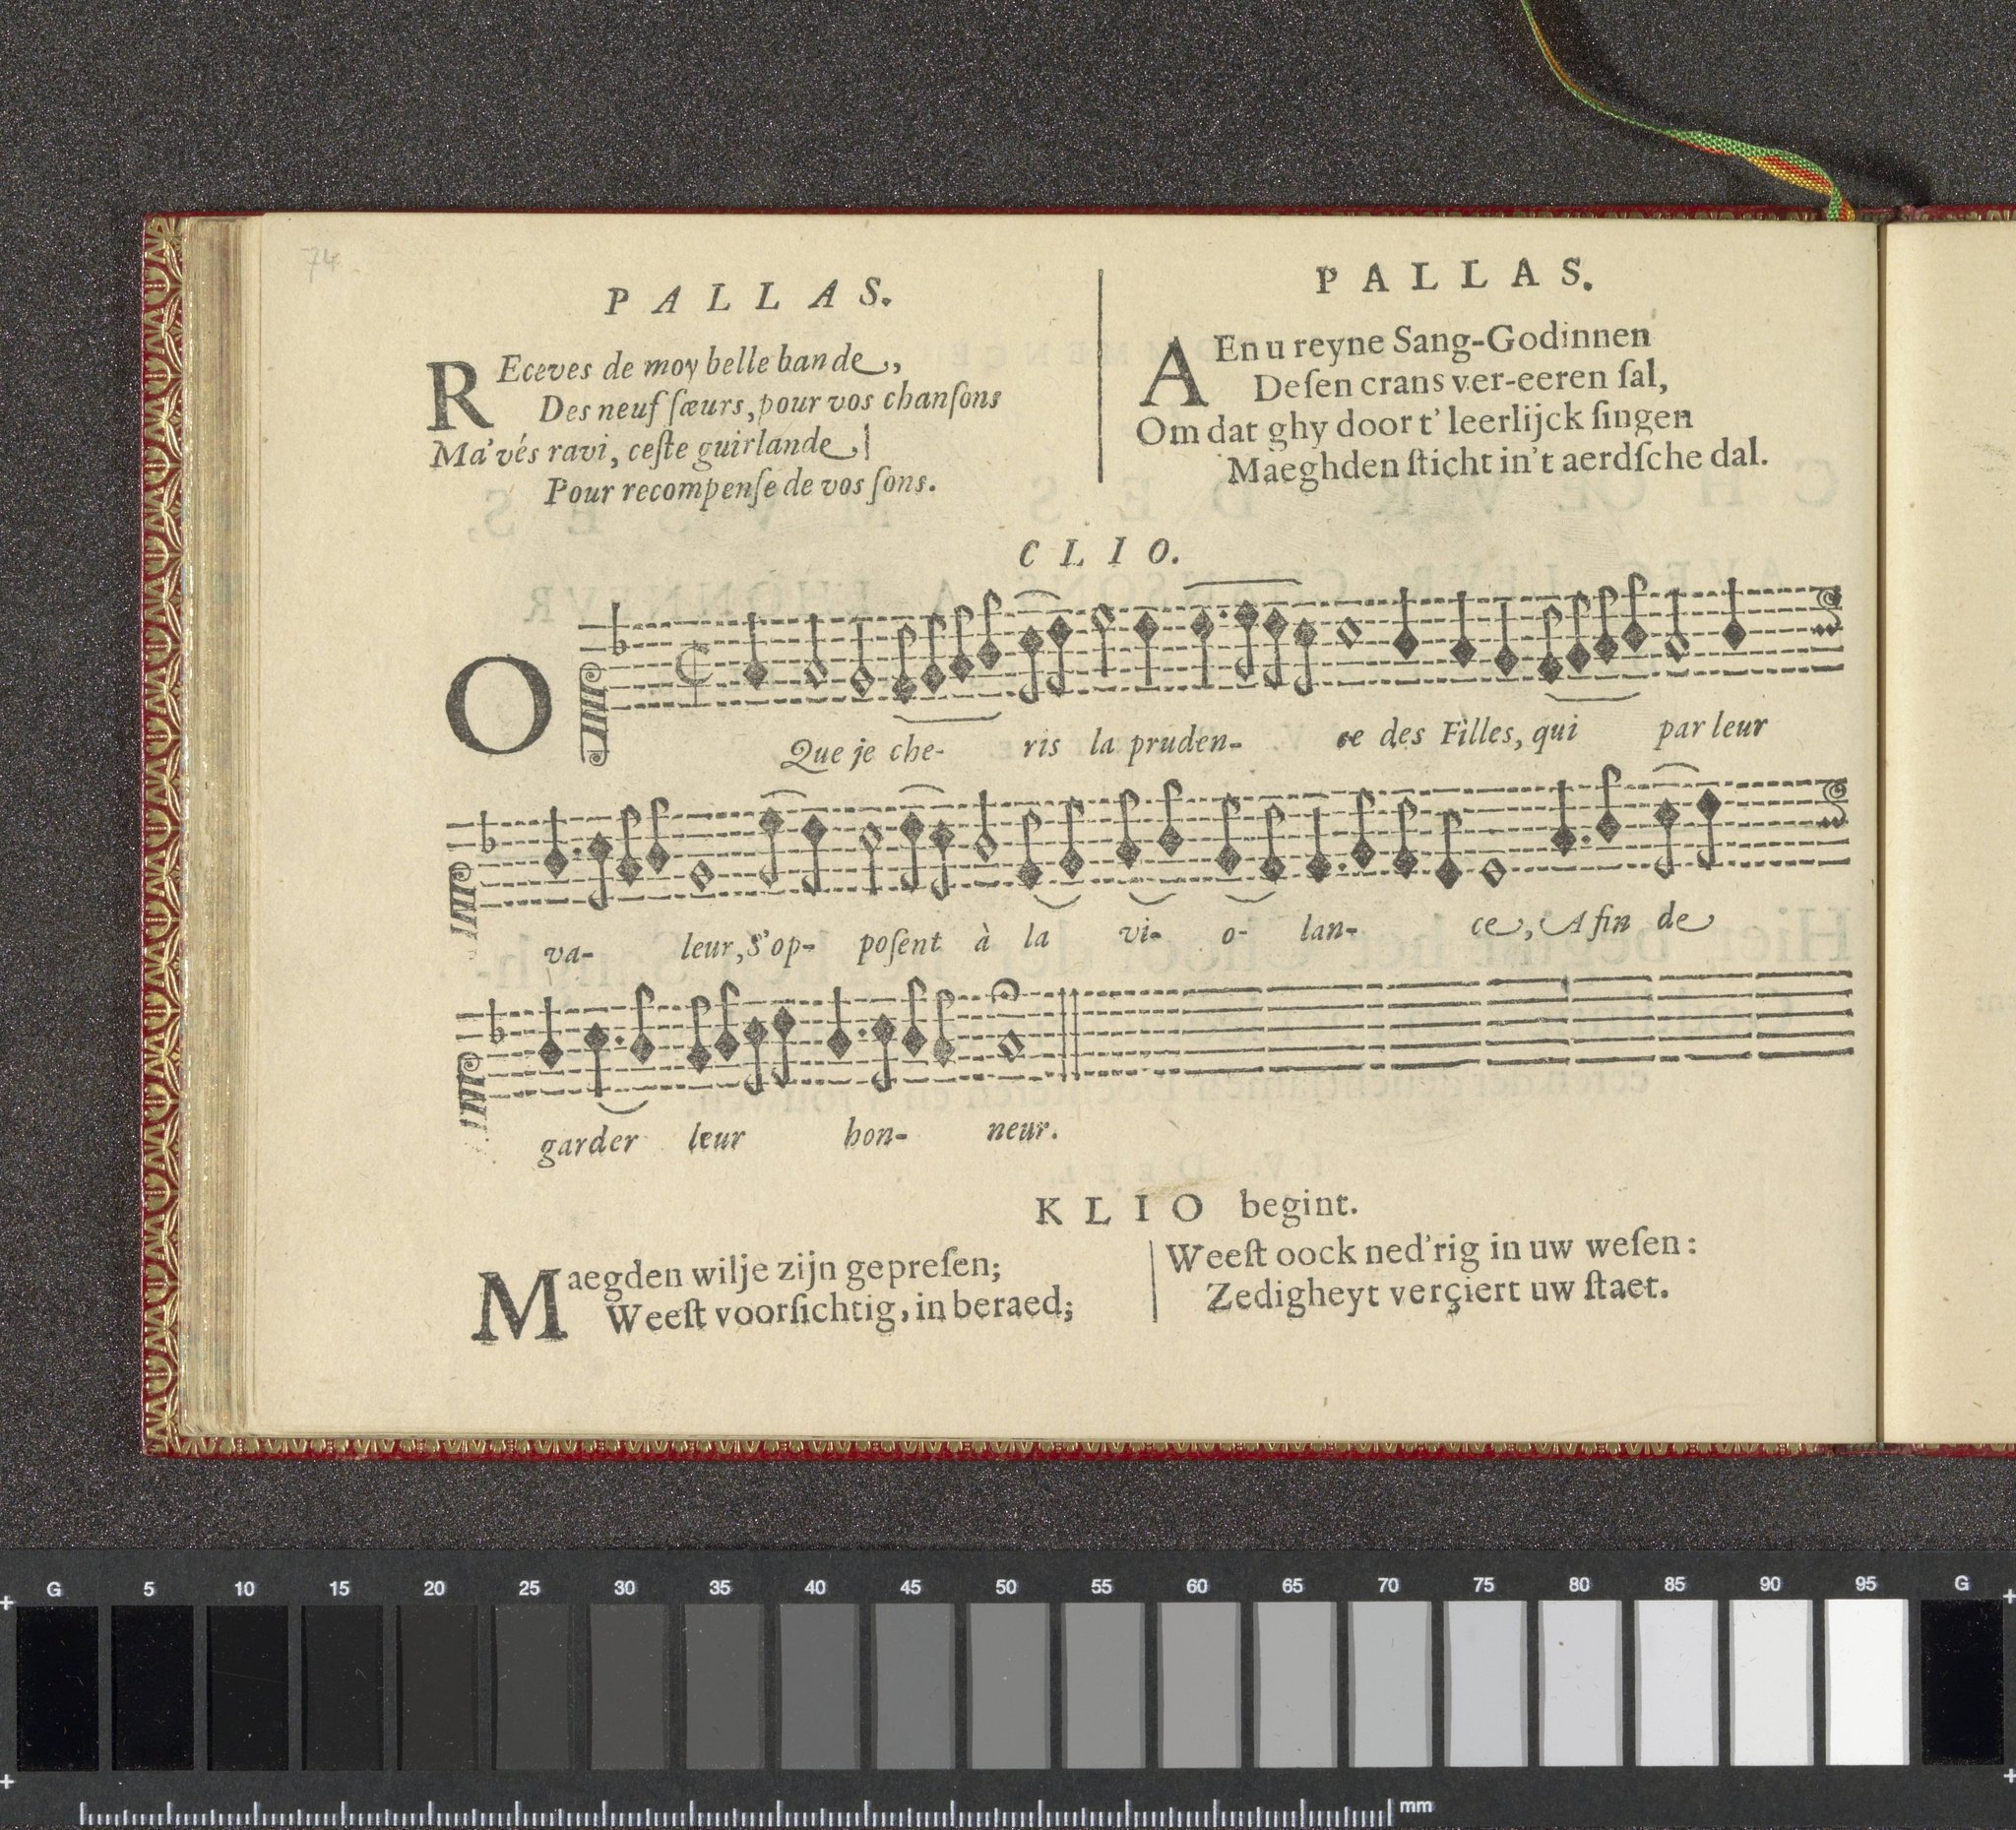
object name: album leaf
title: Les vrais pourtraits de quelques unes des plus grandes dames de la chrestiente desguisees en bergeres.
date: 1640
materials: paper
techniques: letterpress printing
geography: amsterdam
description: Twee keer twee kwatrijnen in het Frans en Nederlands bij de voorstellingen van Minerva en Clio. Het Franstalige kwatrijn bij Clio onder drie notenbalken. Het blad maakt deel uit van een album.